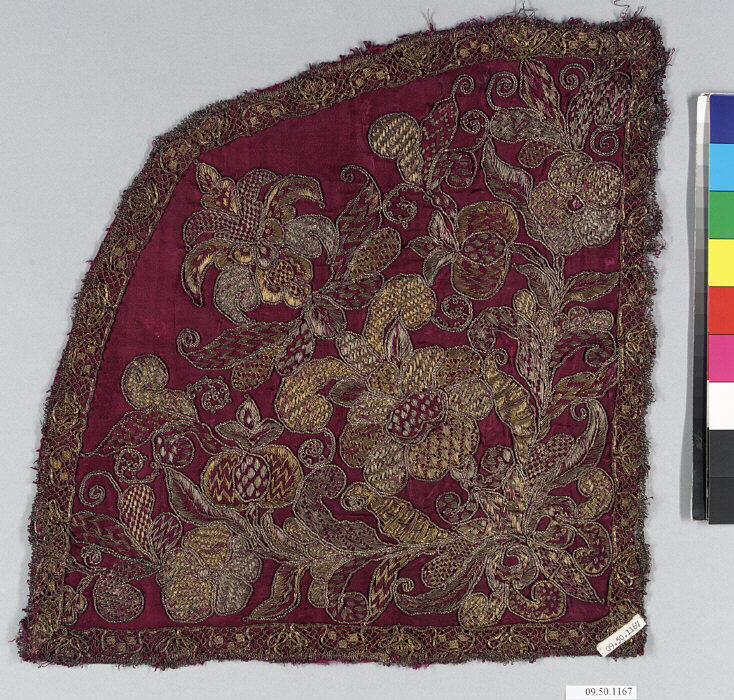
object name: panel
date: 1601-1700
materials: lace, metal, metal thread, silk